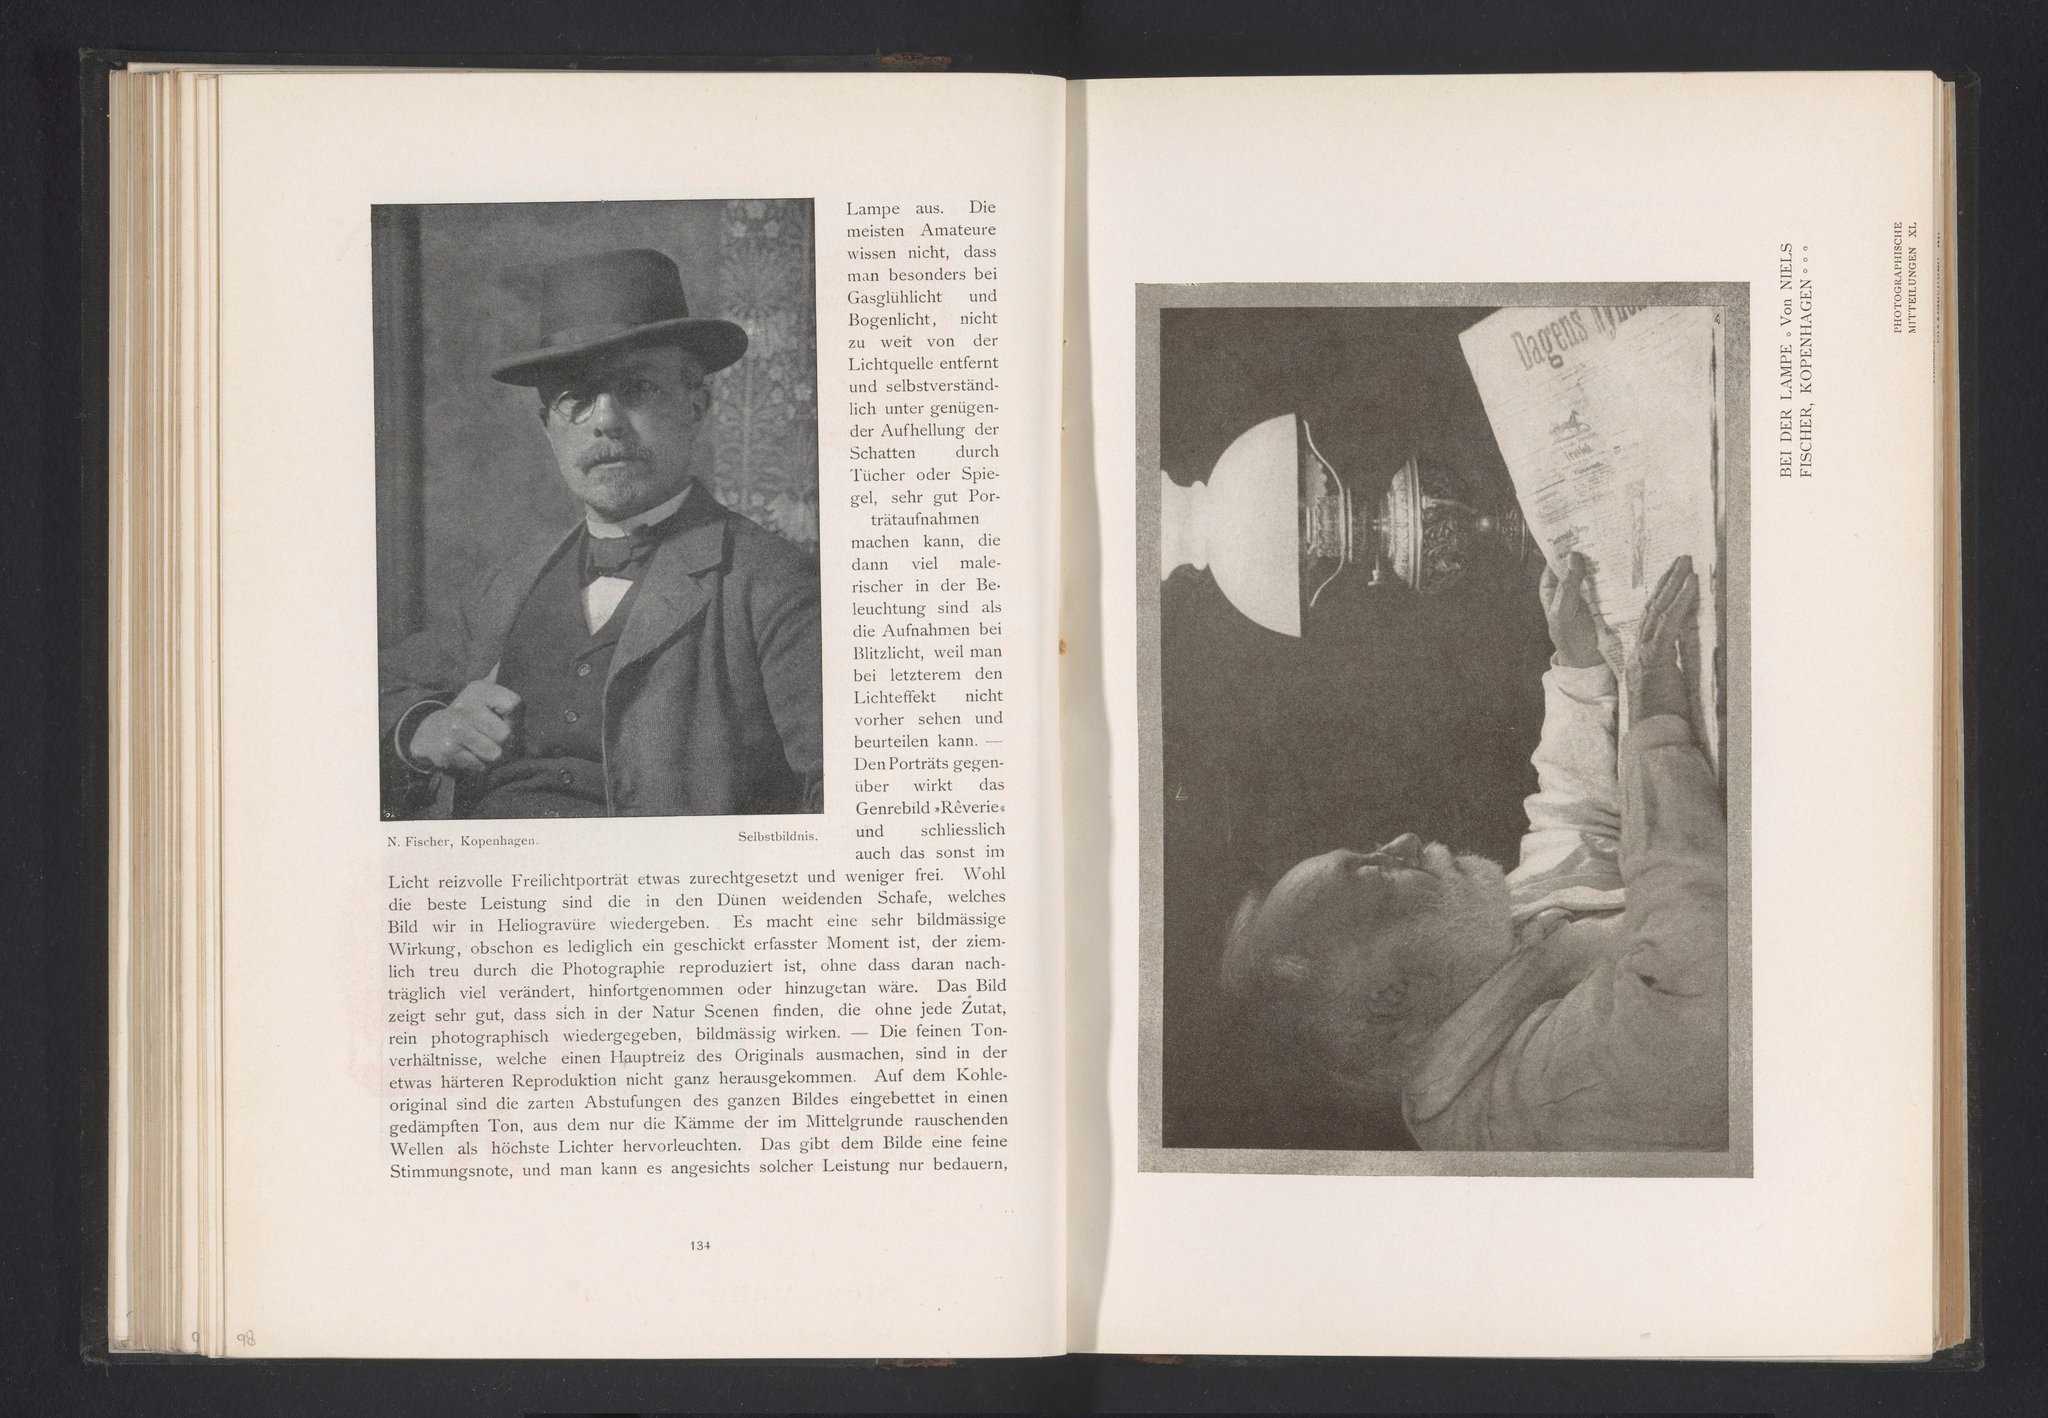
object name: page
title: Bei der lampe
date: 1898-1903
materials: paper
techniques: autotype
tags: historical persons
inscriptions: inscription: ‘Kopenhagen’, monogram: ‘BX’, inscription: ‘Photographische Mitteilungen XL’